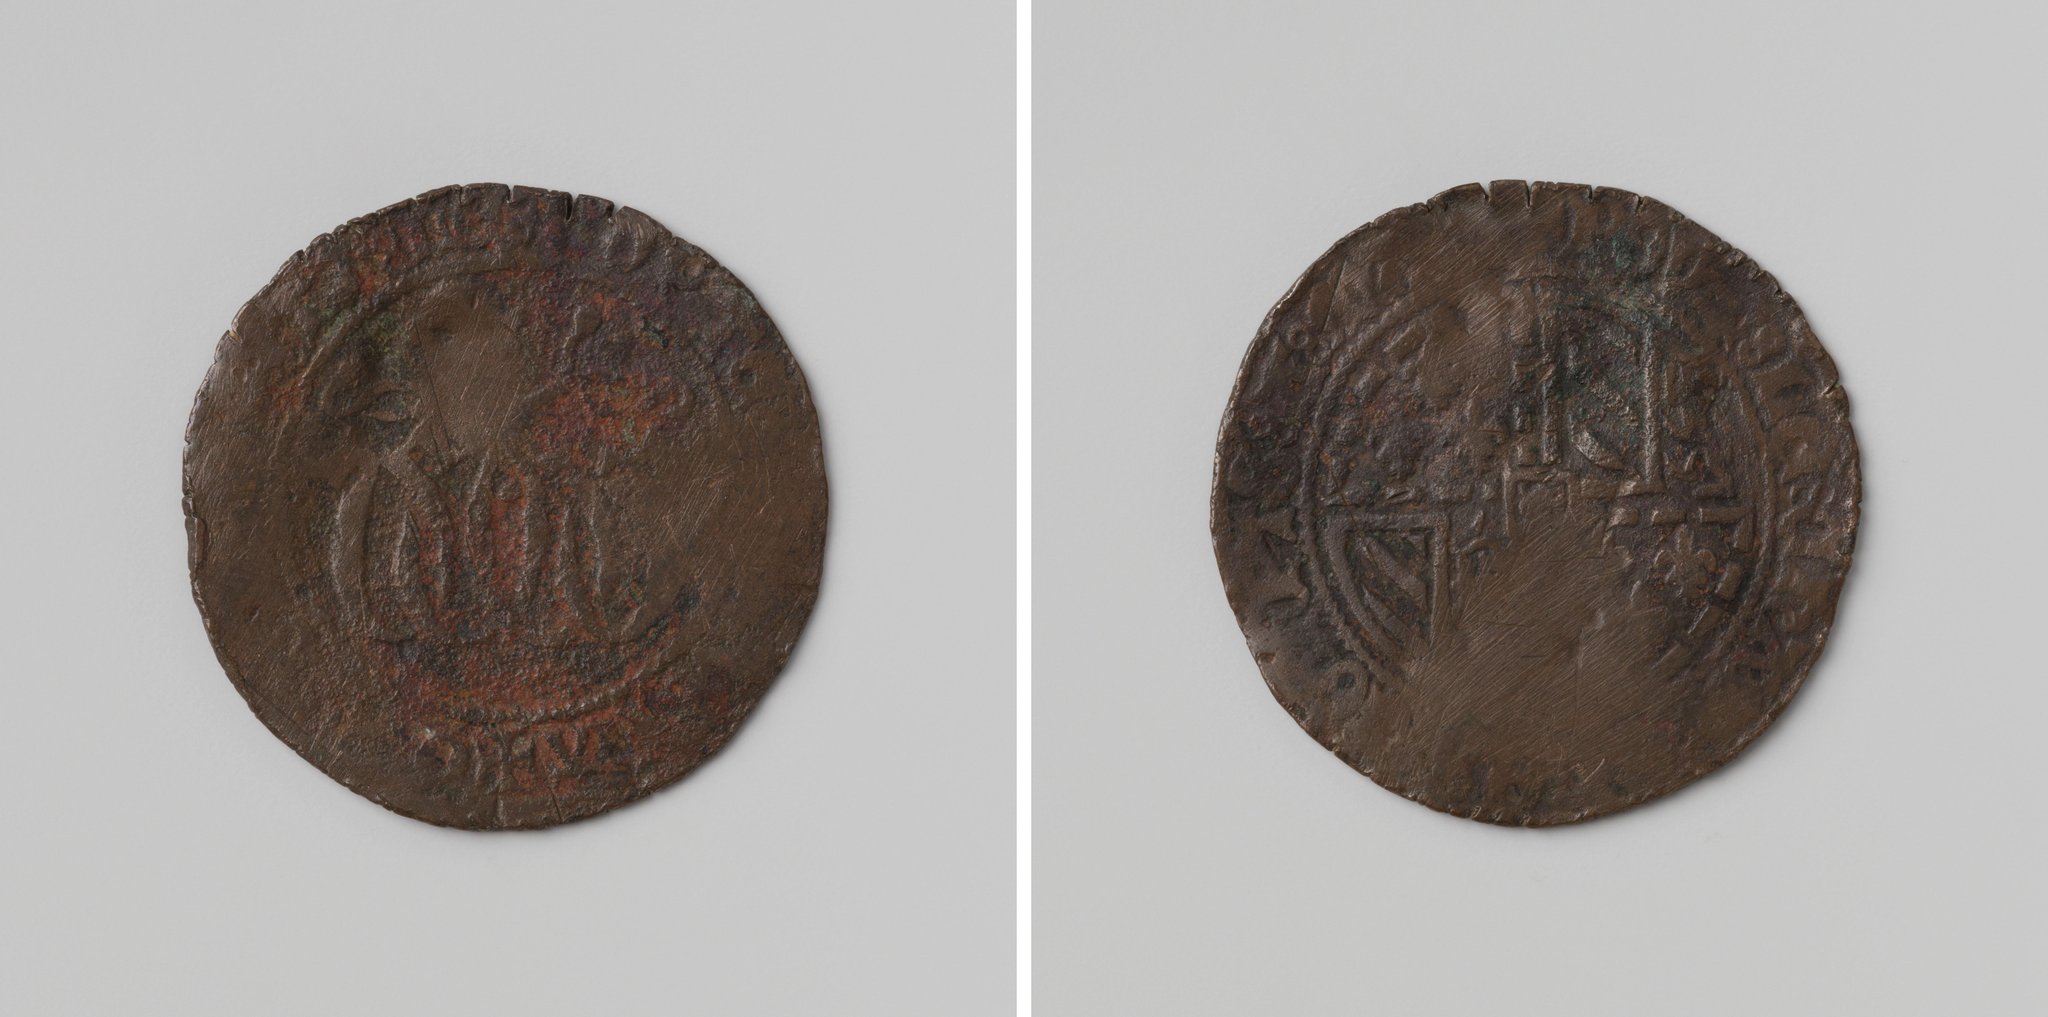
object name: jeton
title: Maximiliaan, aartshertog van Oostenrijk, en Maria, hertogin van Bourgondie, rekenpenning van de rekenkamer te Mechelen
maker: Anonymous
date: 1478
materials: copper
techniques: striking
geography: mechelen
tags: bruges, maria (hertogin van bourgondië), maximilian i (holy roman emperor), mechelen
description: Koperen penning. Voorzijde: twee verweven, Gothische letters M; daartussen letter I binnen omschrift. Keerzijde: wapenschild binnen omschrift